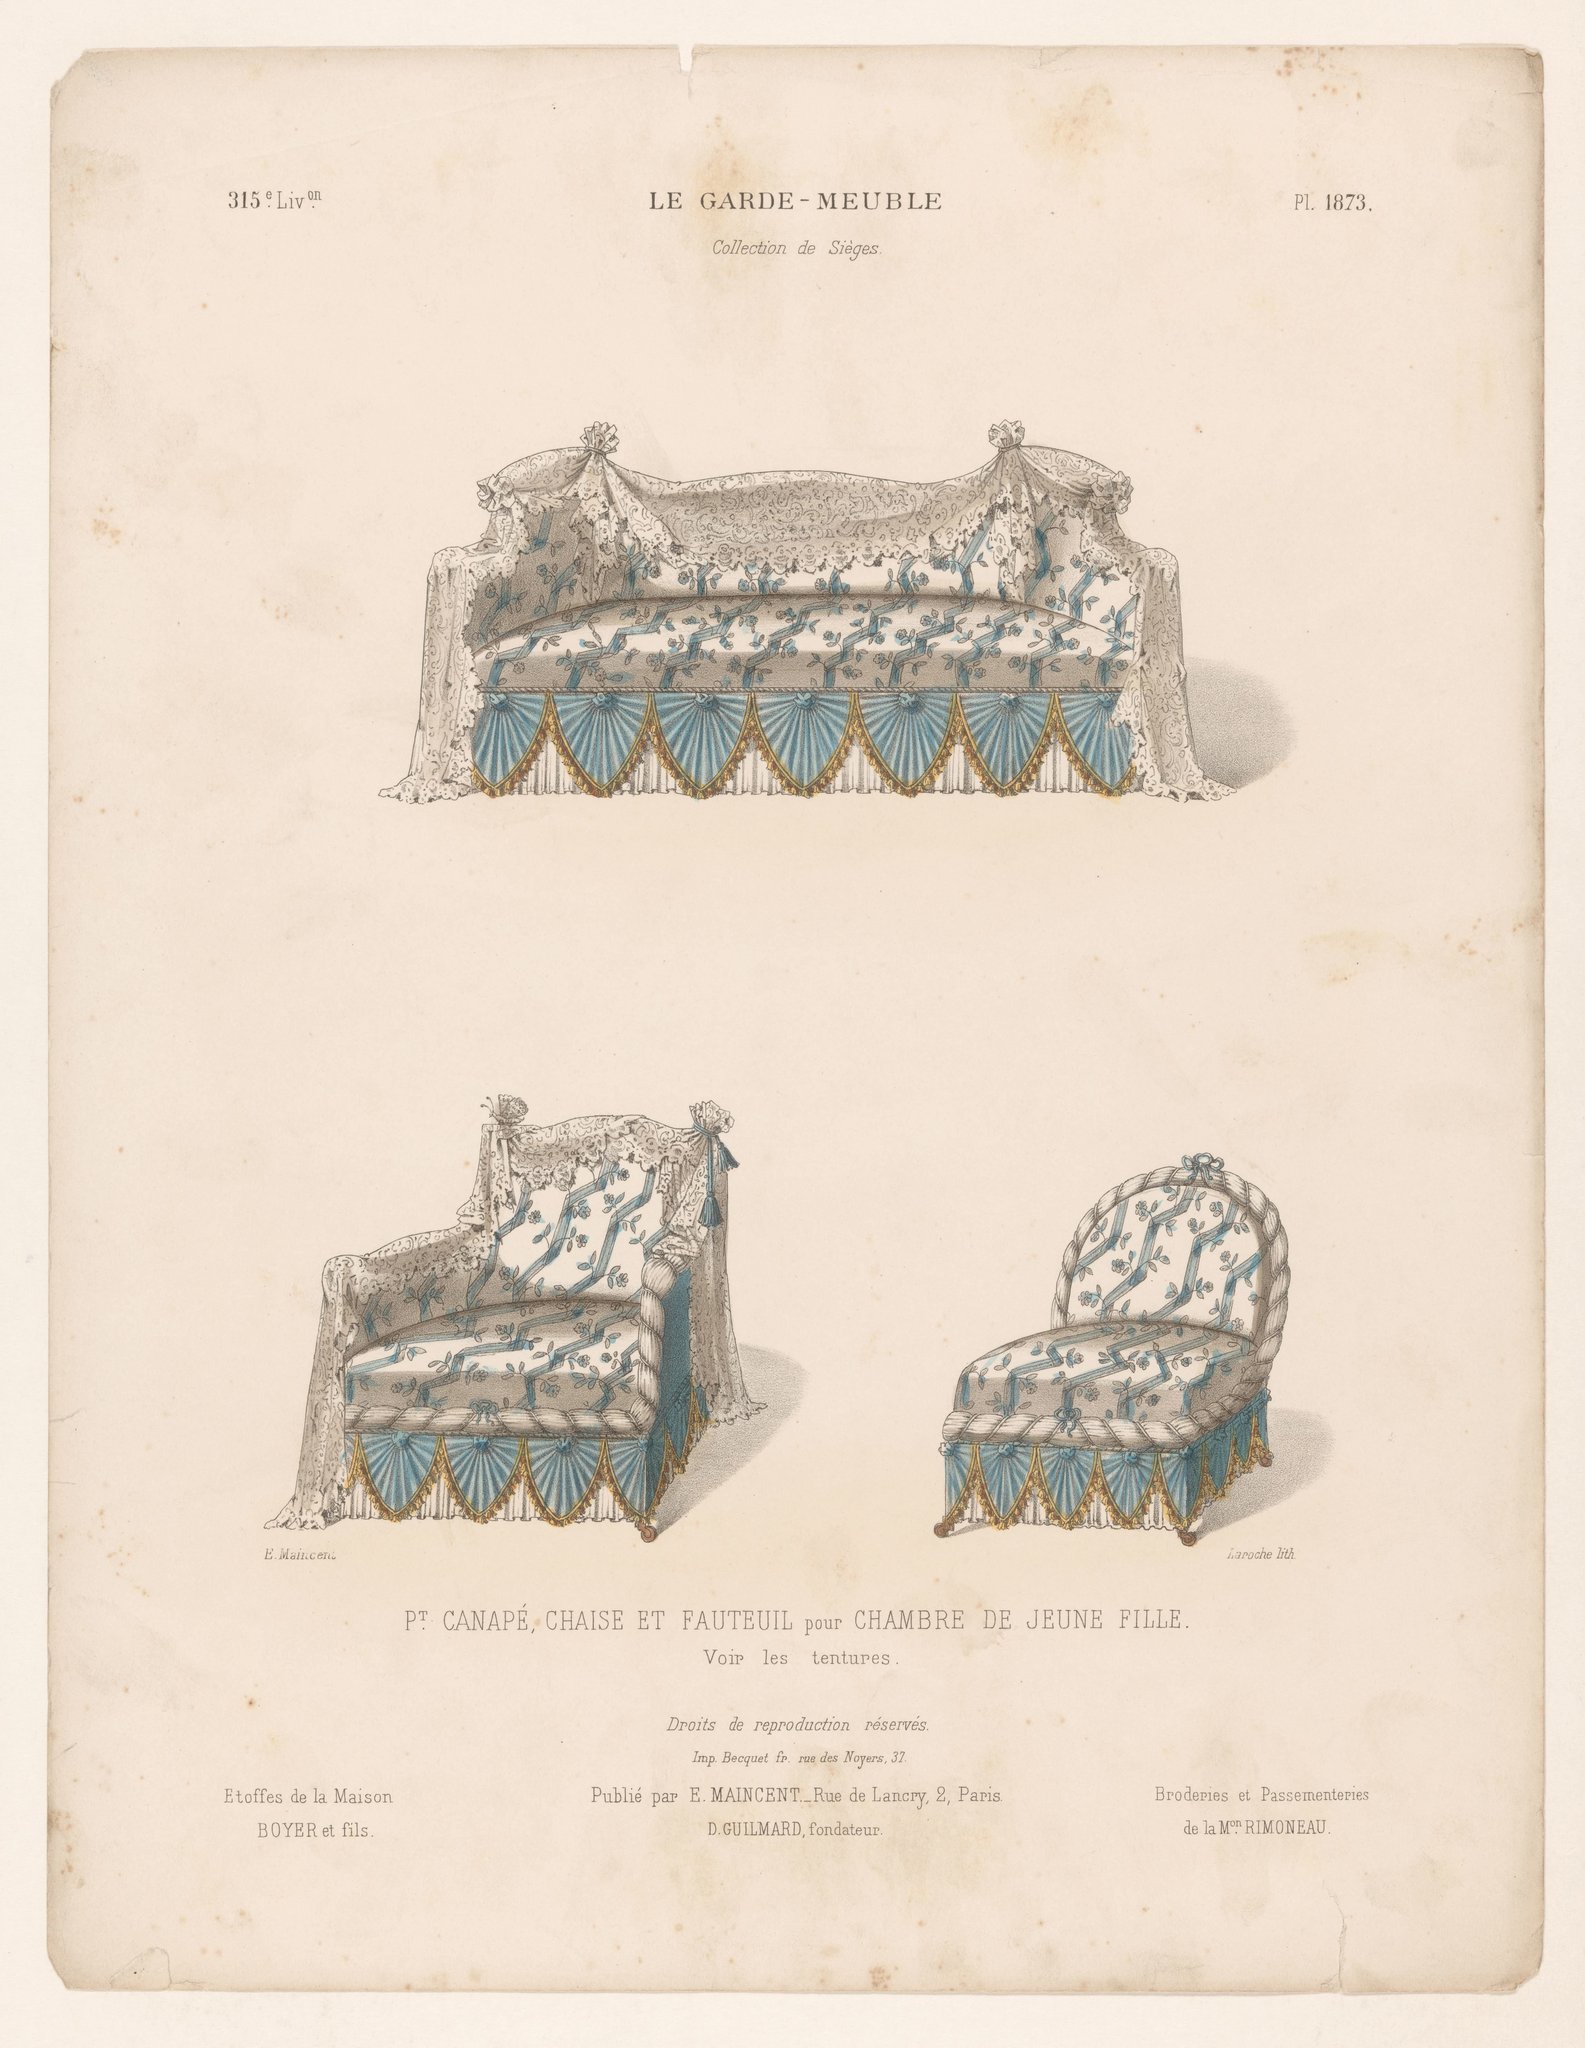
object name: print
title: Pt. canapé, chaise et fauteuil pour chambre de jeune fille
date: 1885-1895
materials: paper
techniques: hand coloring, lithograph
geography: paris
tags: seating furniture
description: Ieder Livraison in de serie Le Garde-Meuble bevat negen platen: drie 'sièges' (zitmeubels), drie 'meubles' (diverse meubels zoals tafels en kasten) en drie 'tentures' (gordijnen en draperieën).